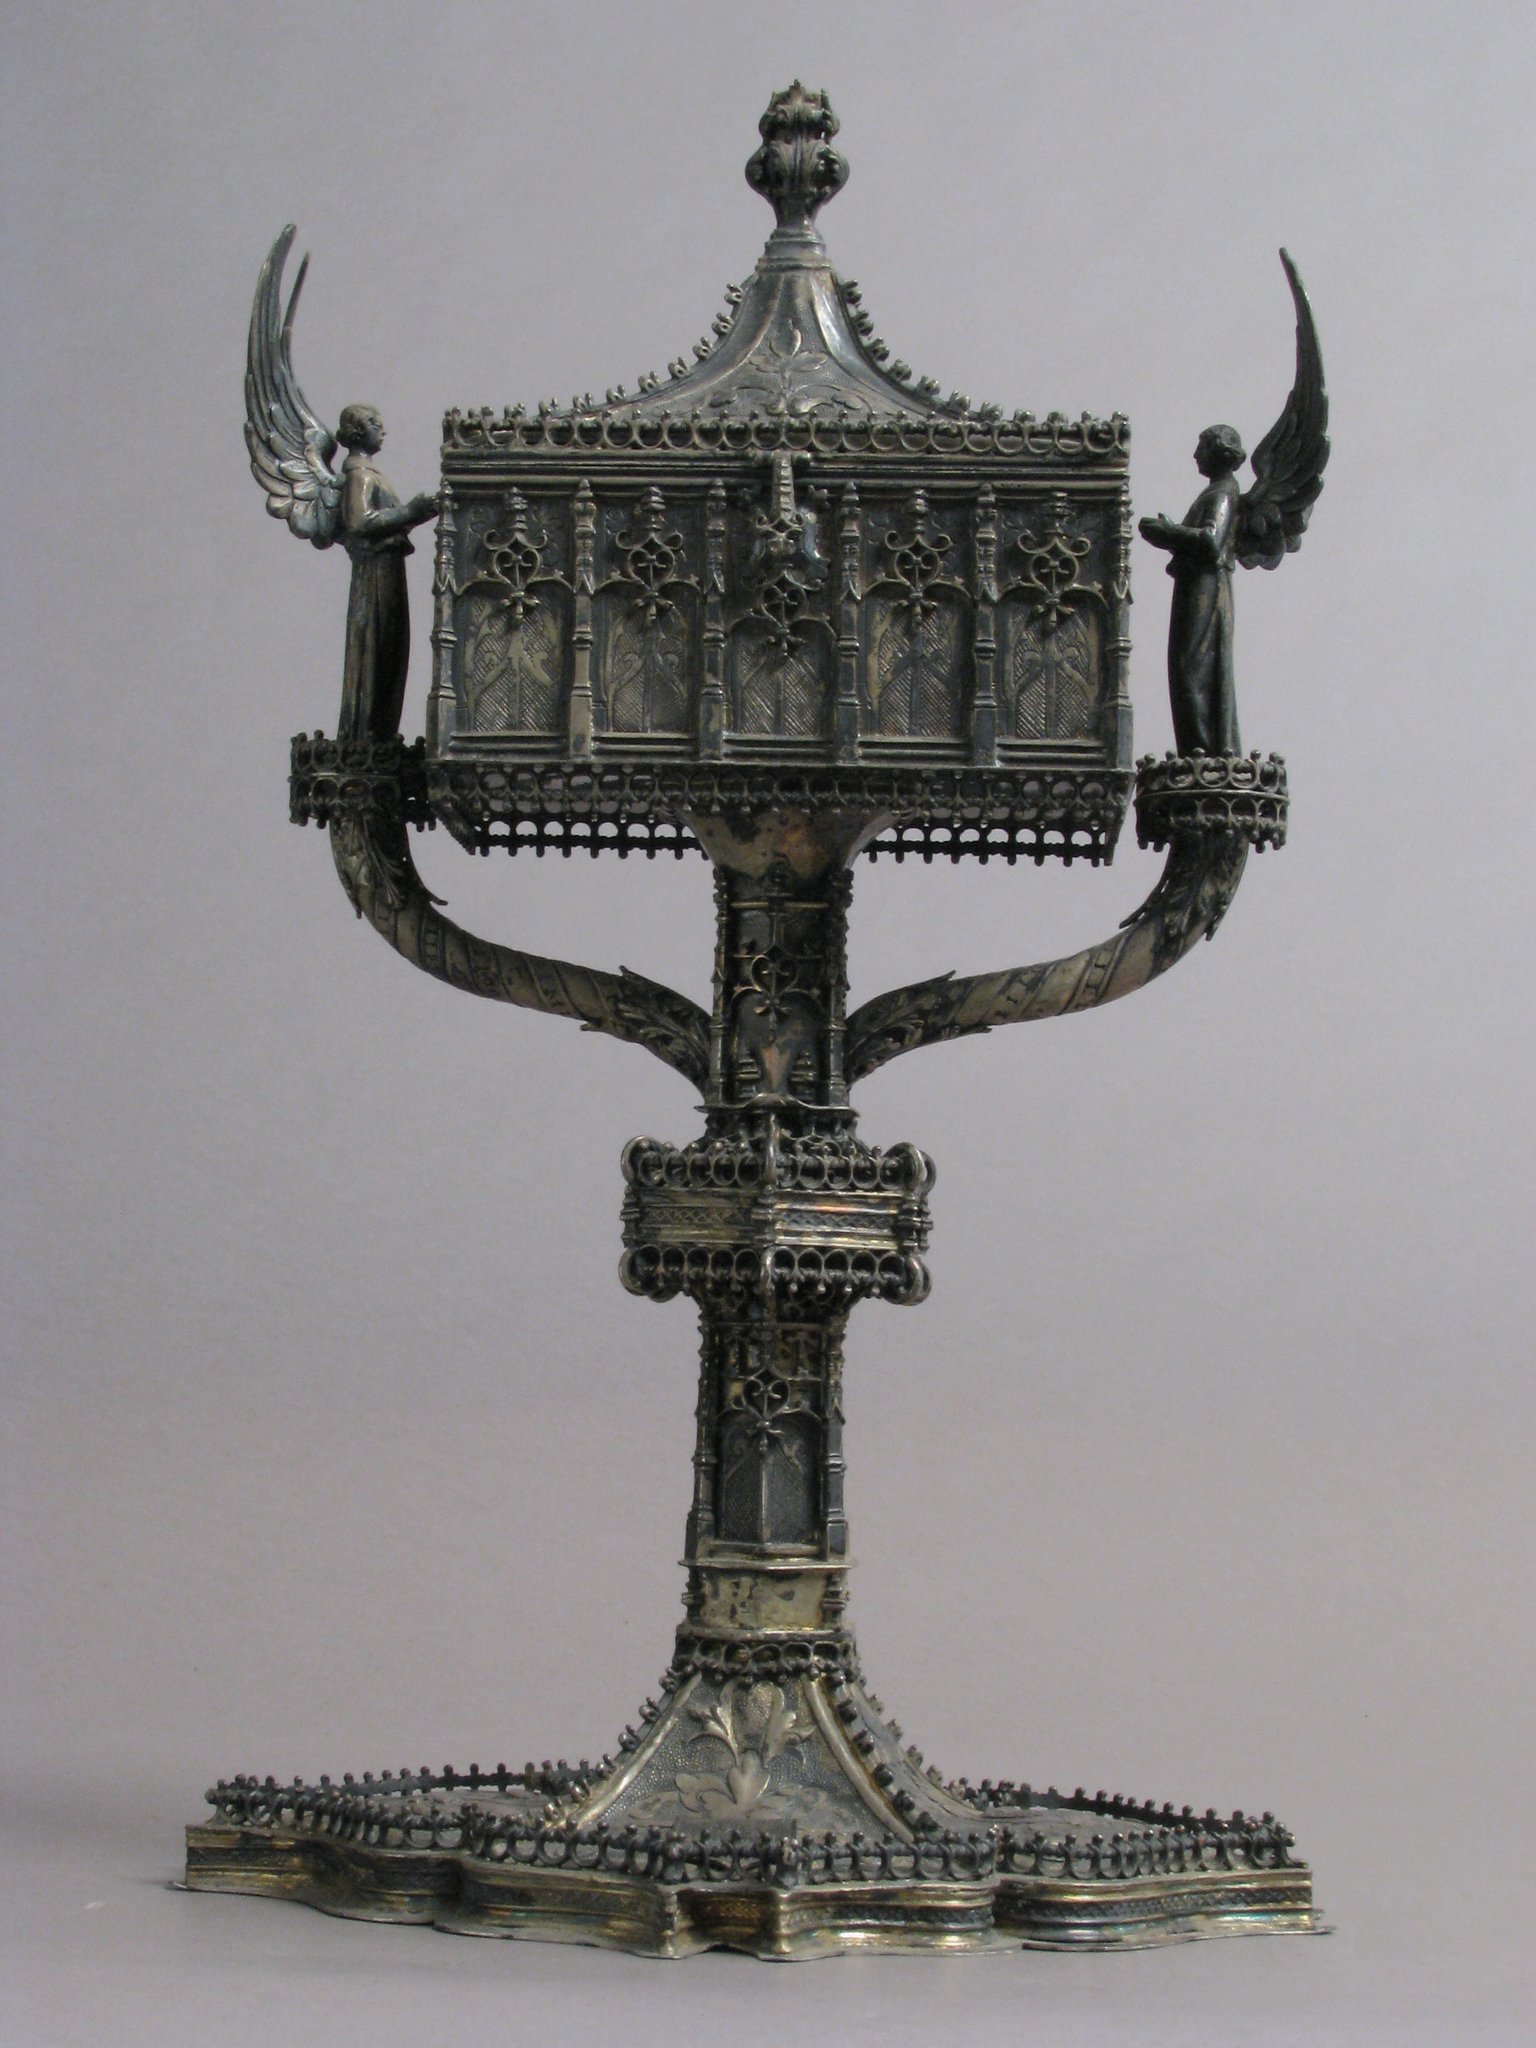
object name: ciborium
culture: spanish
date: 1501-1600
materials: silver gilt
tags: angels